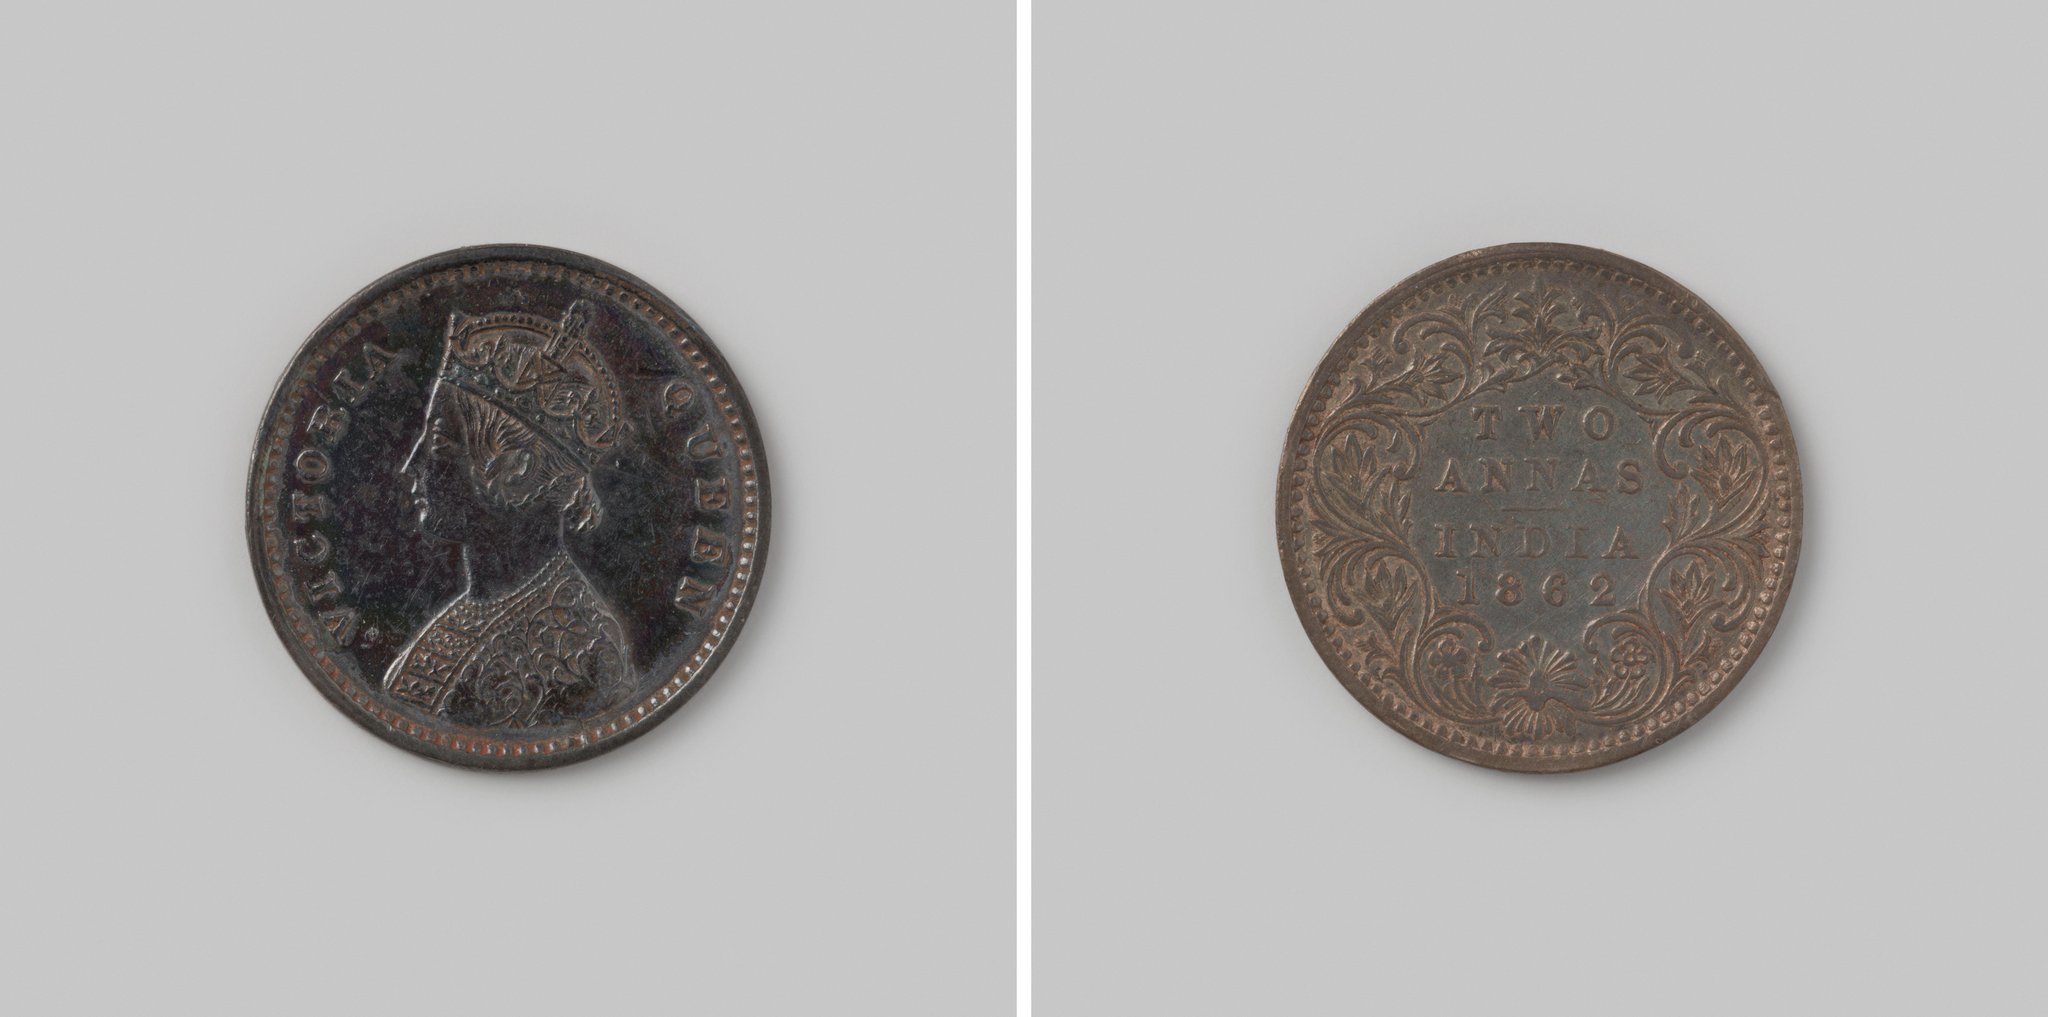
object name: coin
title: 2 annas uit India van koningin Victoria, 1862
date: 1862-1869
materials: silver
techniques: striking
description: Zilveren munt. Voorzijde: gekroond borstbeeld van koningin Victoria naar links. Keerzijde: binnen een kring van lotusbloemen in twee regels waarde-aanduiding: two annas, waaronder lands-aanduiding. Daaronder jaartal. Gladde rand.